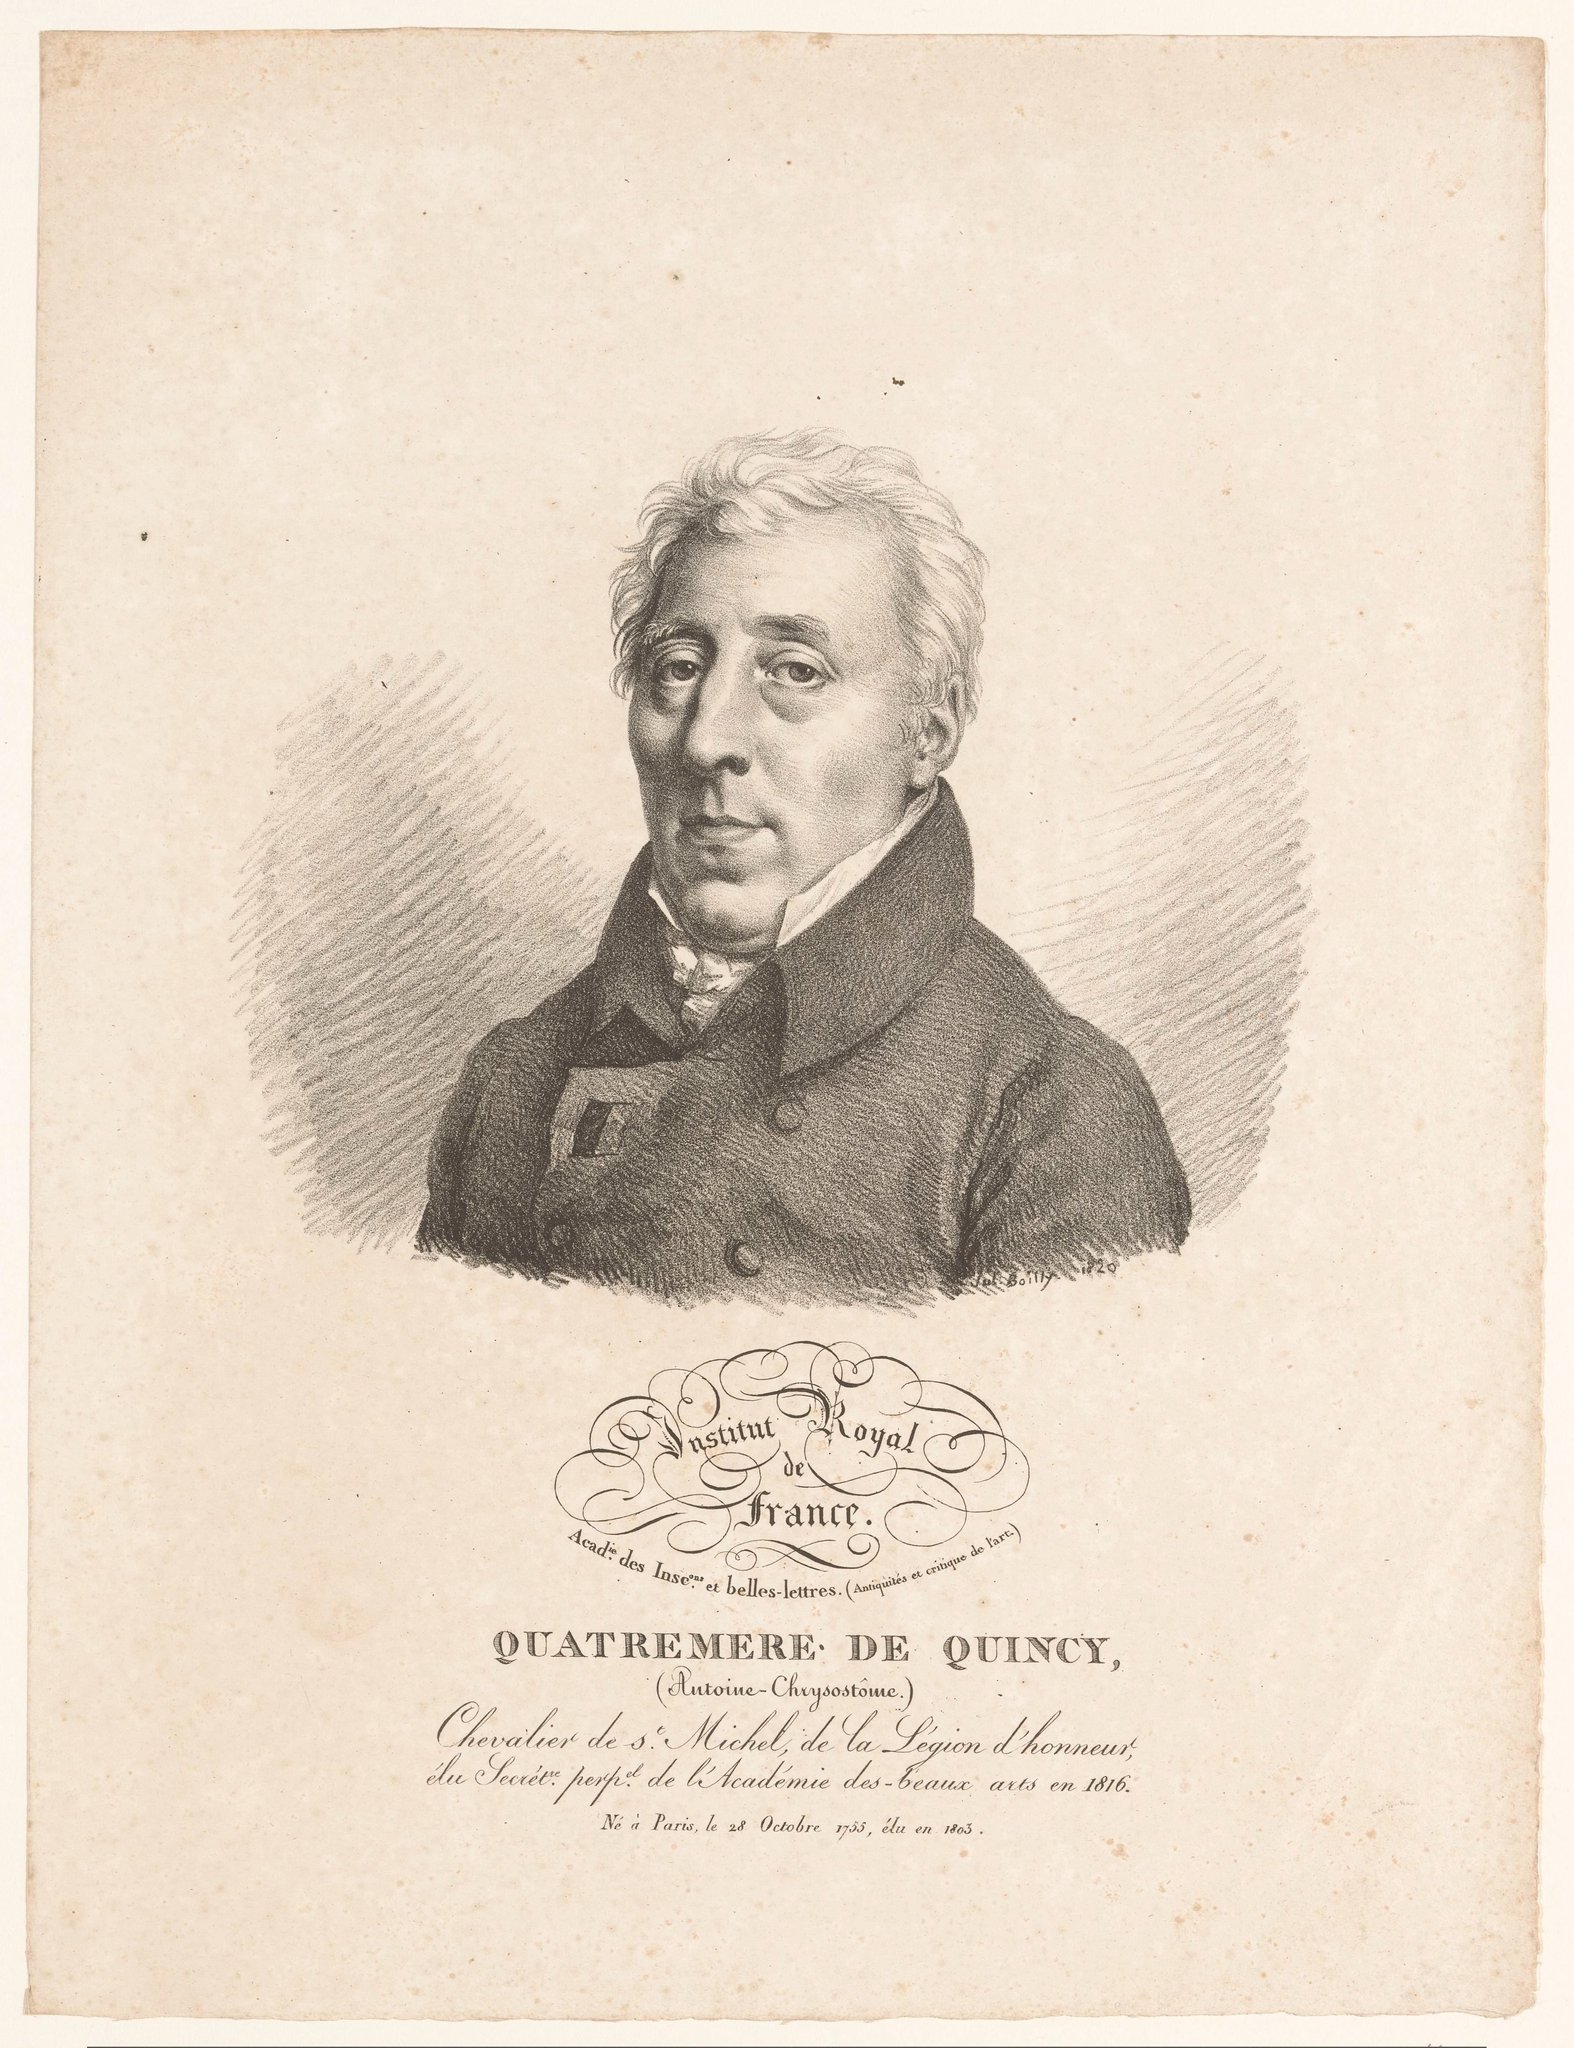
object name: print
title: Iconographie de l'Institut Royal de France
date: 1820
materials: paper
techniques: lithograph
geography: paris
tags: paris, historical persons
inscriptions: collector's mark: Lugt 2228a